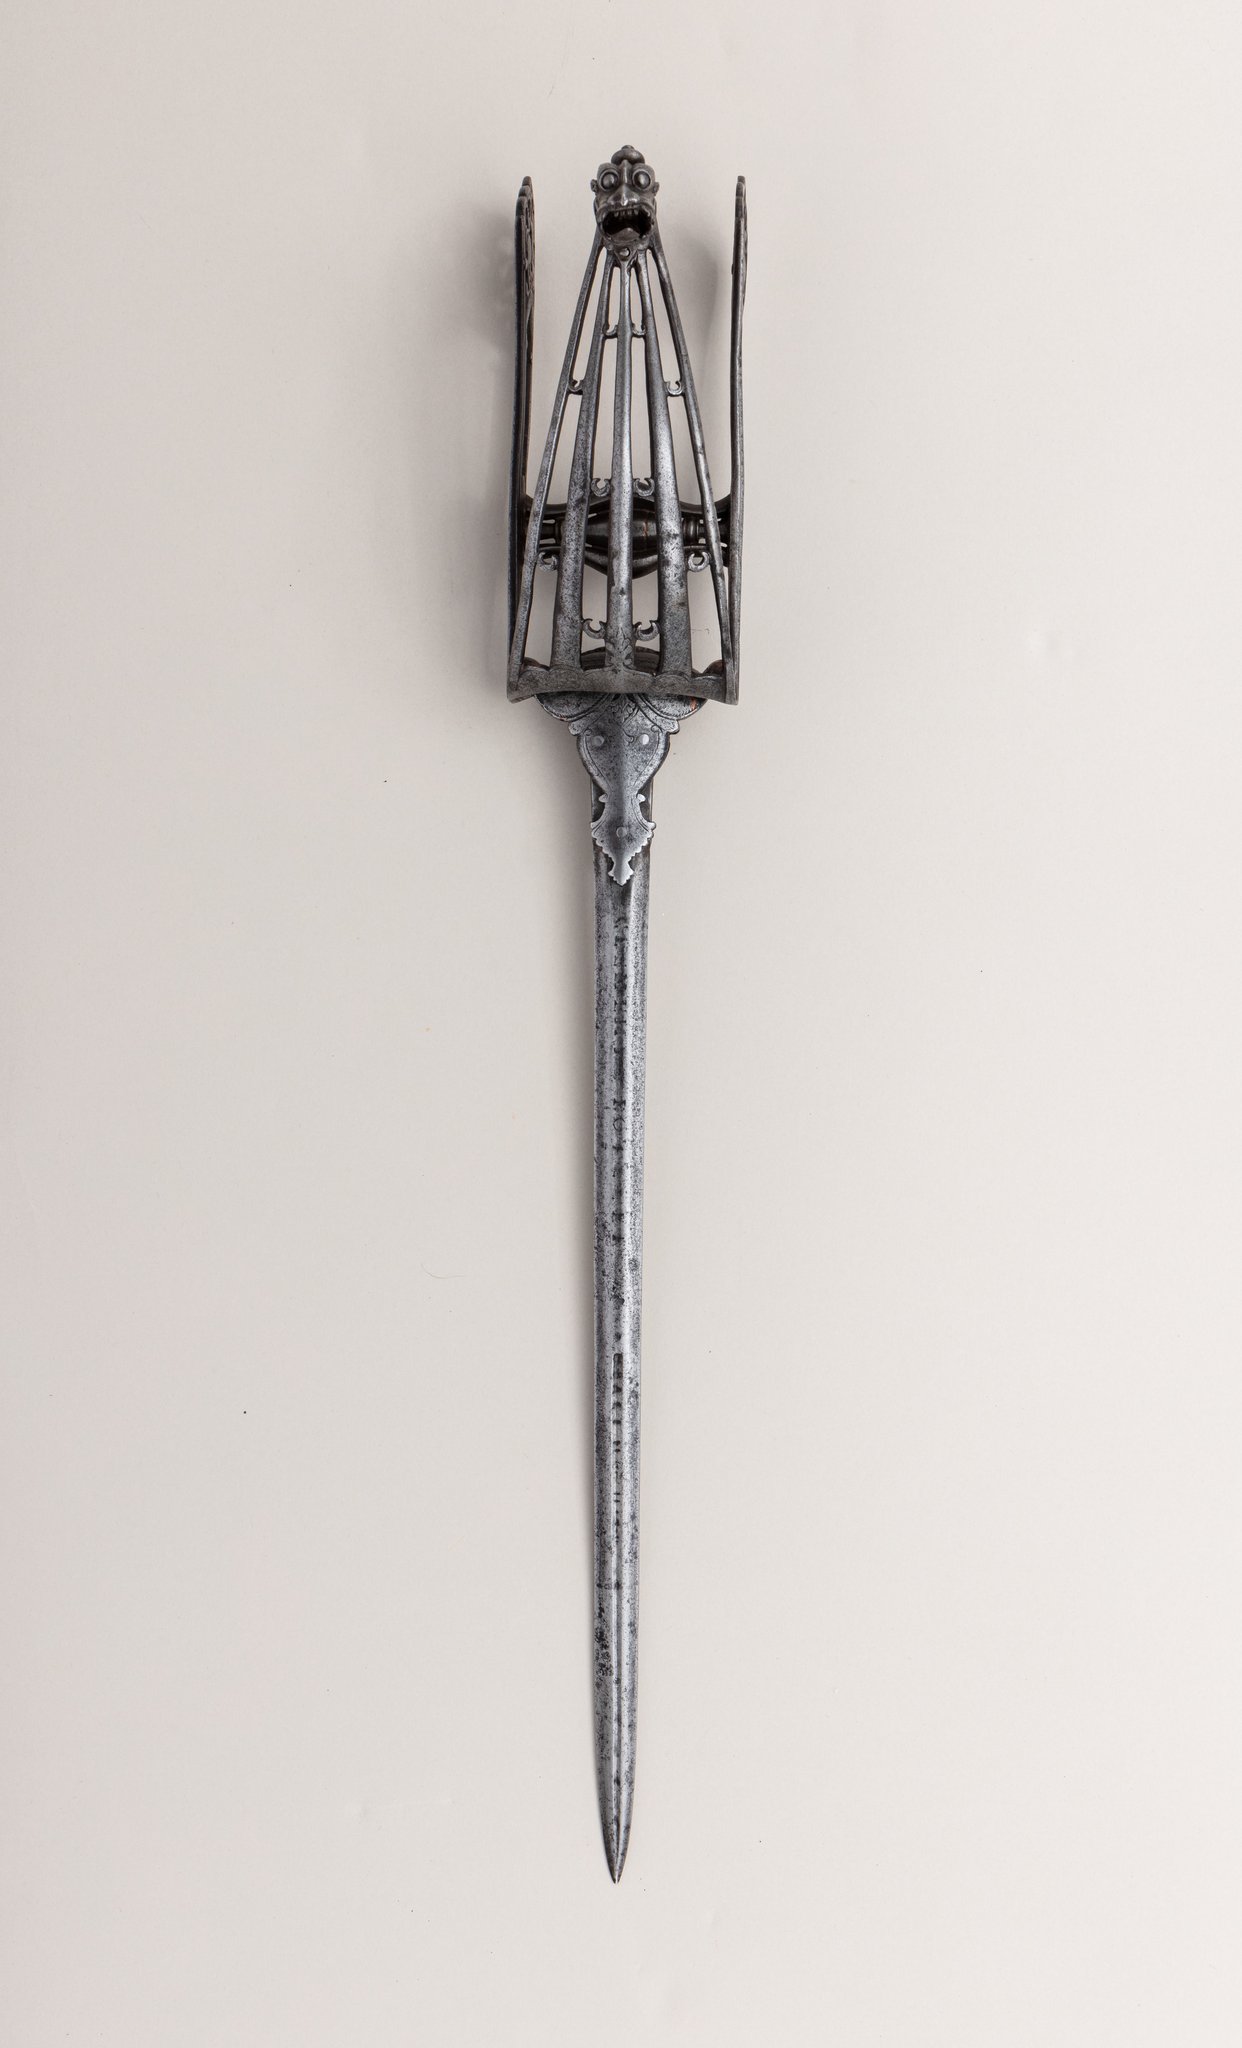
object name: dagger katar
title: Dagger (Katar)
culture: south indian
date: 1601-1700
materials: steel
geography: india